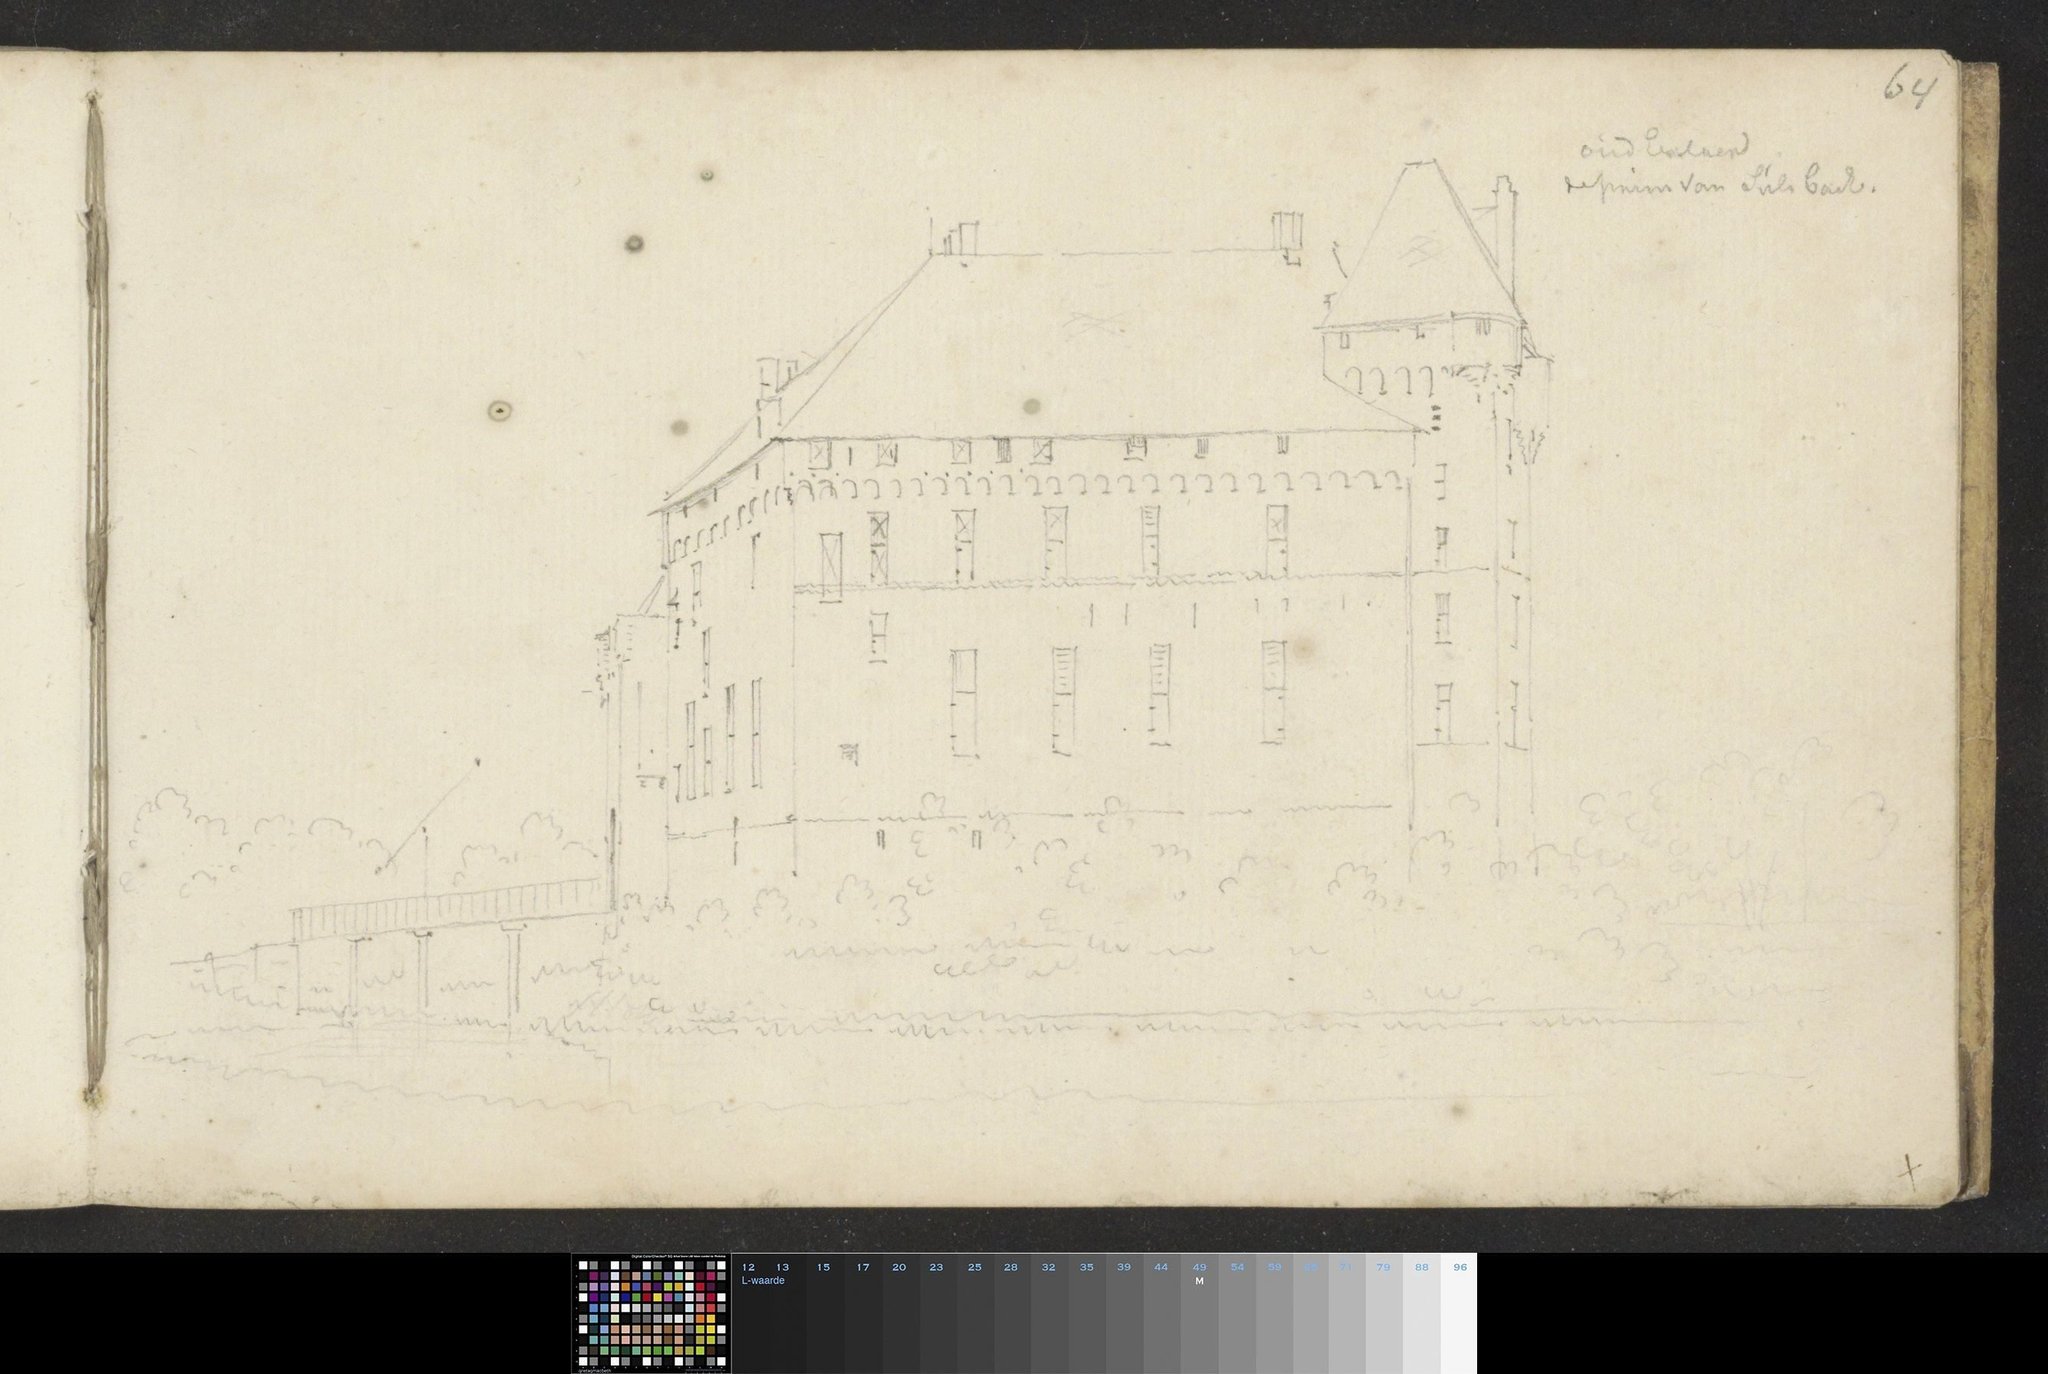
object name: sketchbook leaf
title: Kasteel Oud-Herlaer bij Sint-Michielsgestel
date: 1701-1759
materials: paper, pencil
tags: castle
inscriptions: annotation: ‘oud herlaer. / dep[...] van [...]’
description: Blad 64 recto uit een schetsboek met 65 bladen.